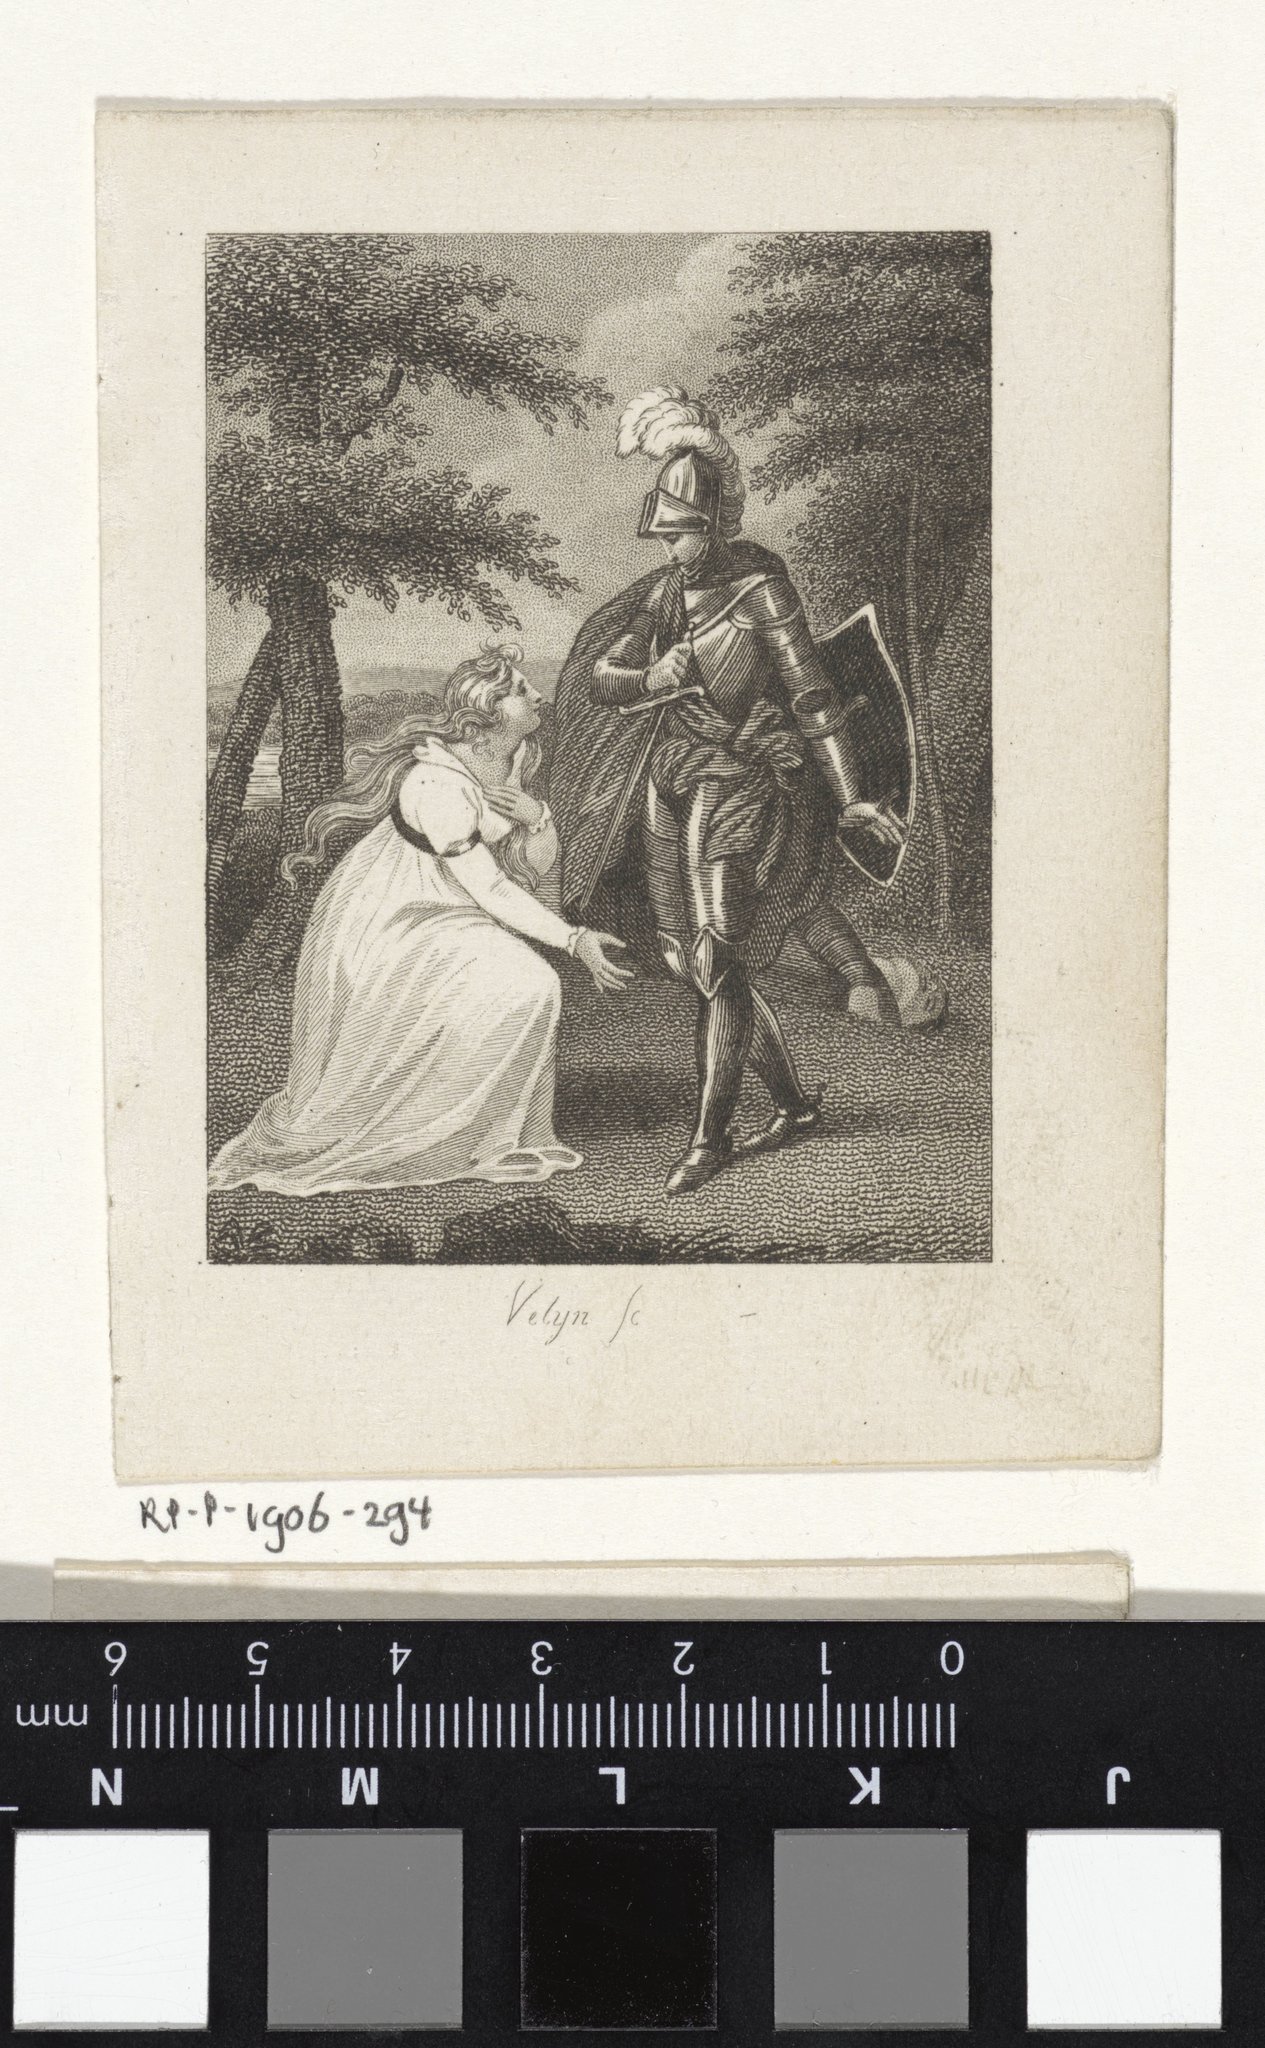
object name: print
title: Knielende vrouw voor een ridder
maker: philippus velijn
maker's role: print maker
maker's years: 1787-1836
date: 1822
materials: paper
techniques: engraving, etching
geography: netherlands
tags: adolescent, young woman, maiden, kneeling figure - aa - female human figure, armour, knight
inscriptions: collector's mark: Lugt 2228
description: Prent ook gebruikt als boekillustratie in: Almanak aan bevalligheid en deugd gewijd. Amsterdam: M. Westerman, 1822.